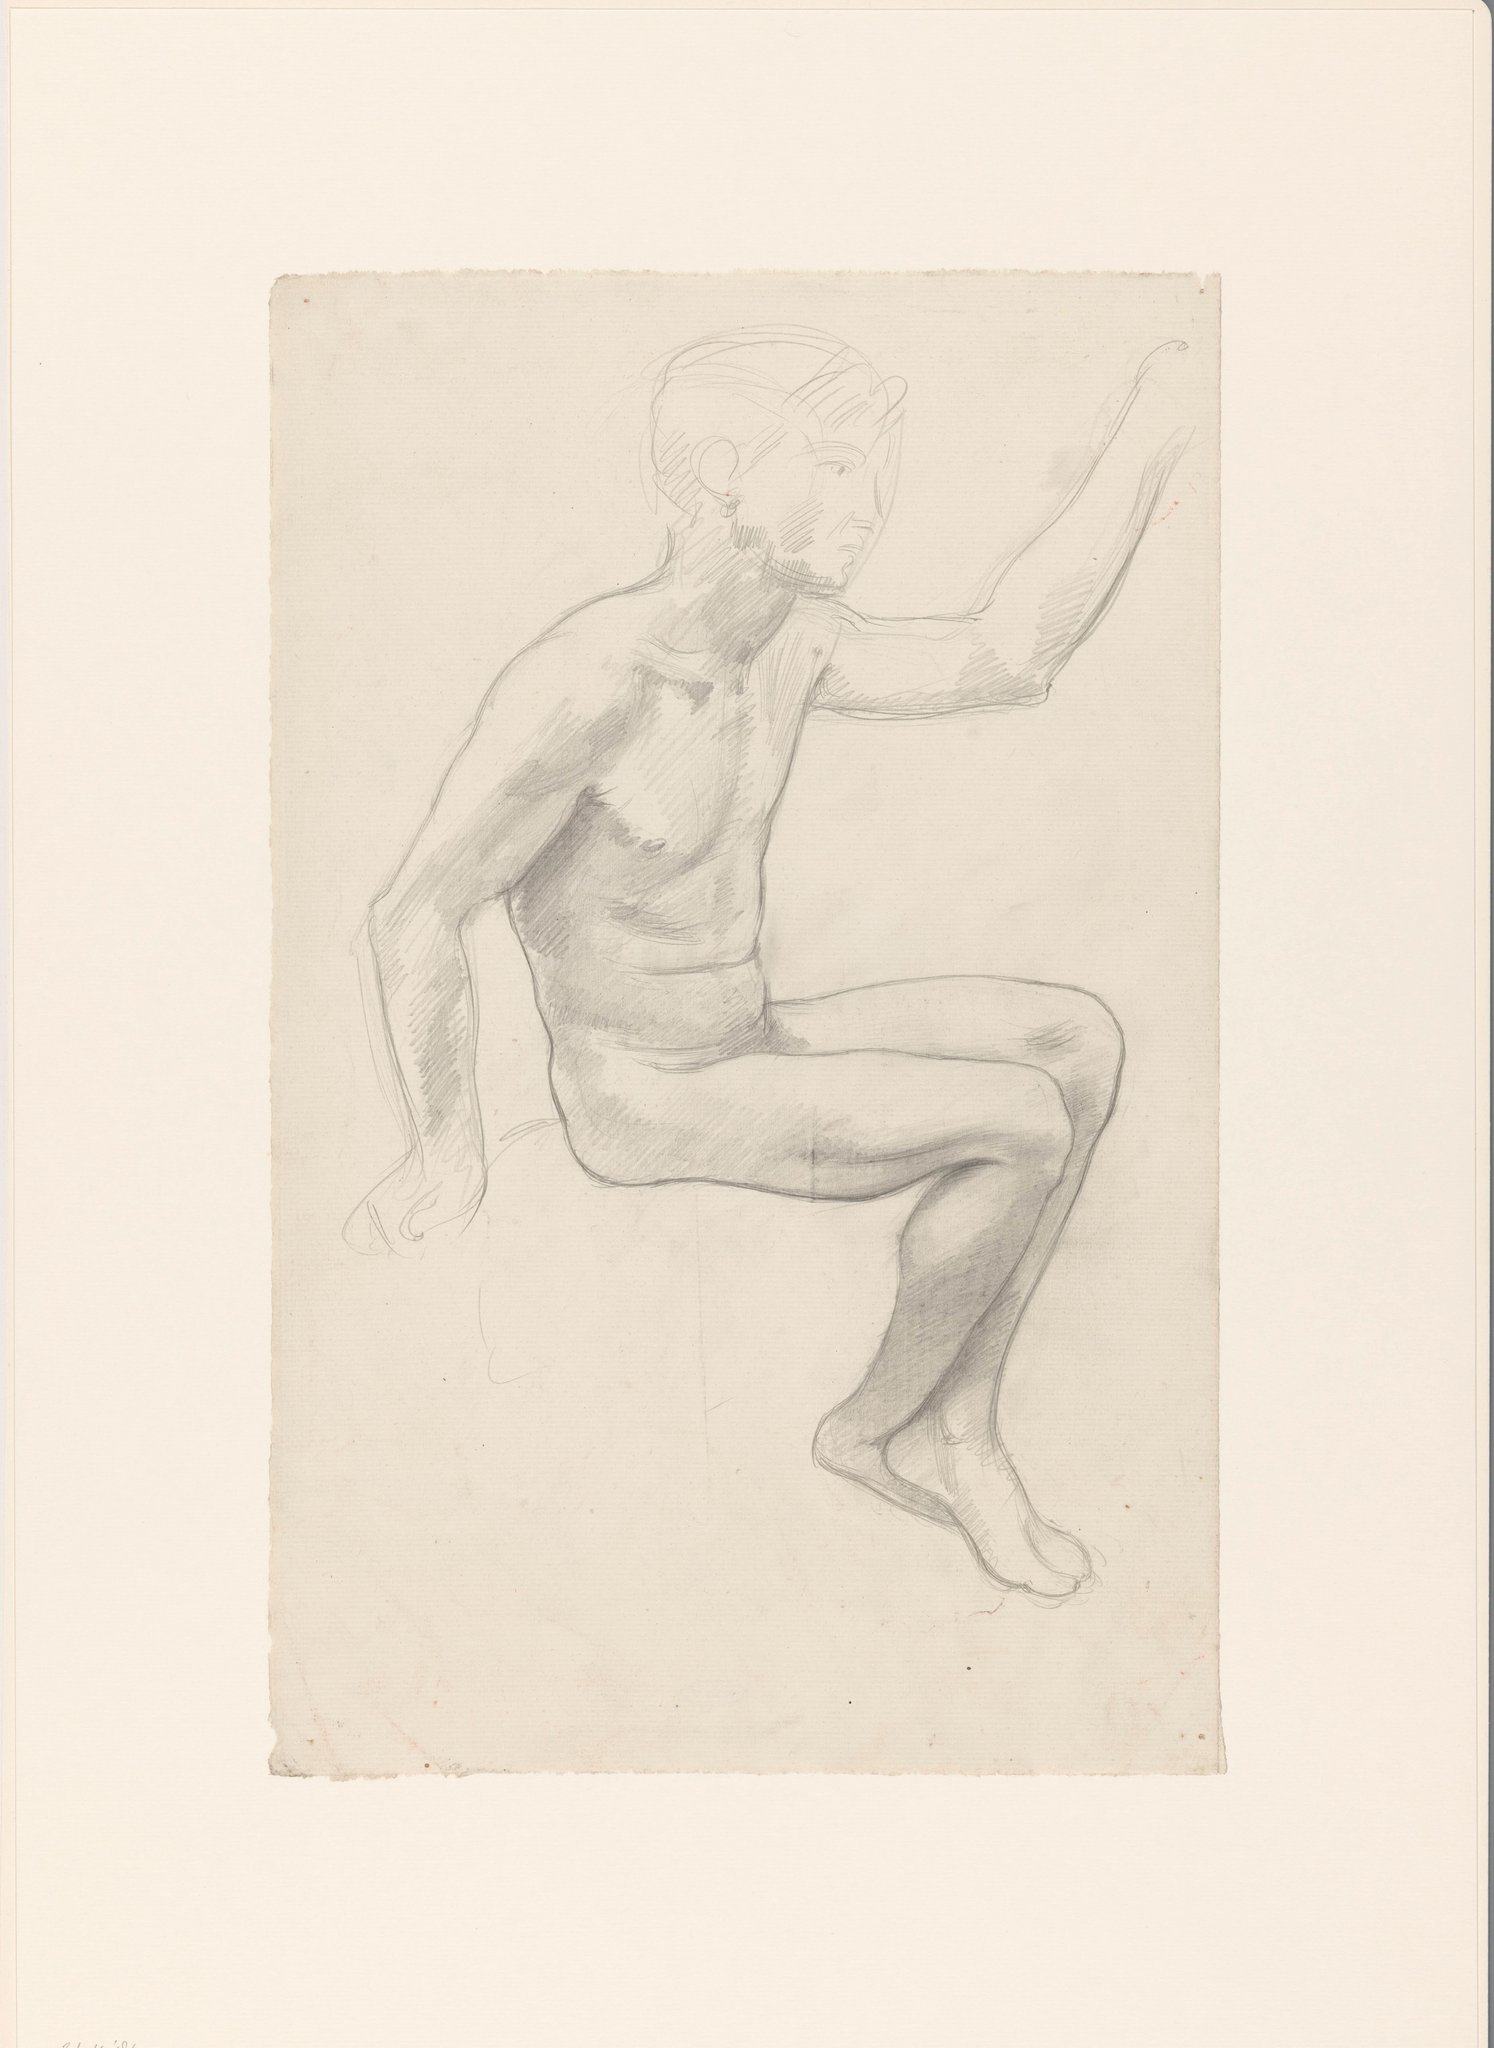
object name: drawing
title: Zittende naakte jongen met opgeheven arm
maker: richard nicolaüs roland holst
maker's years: 1868-1938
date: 1878-1938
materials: paper, pencil